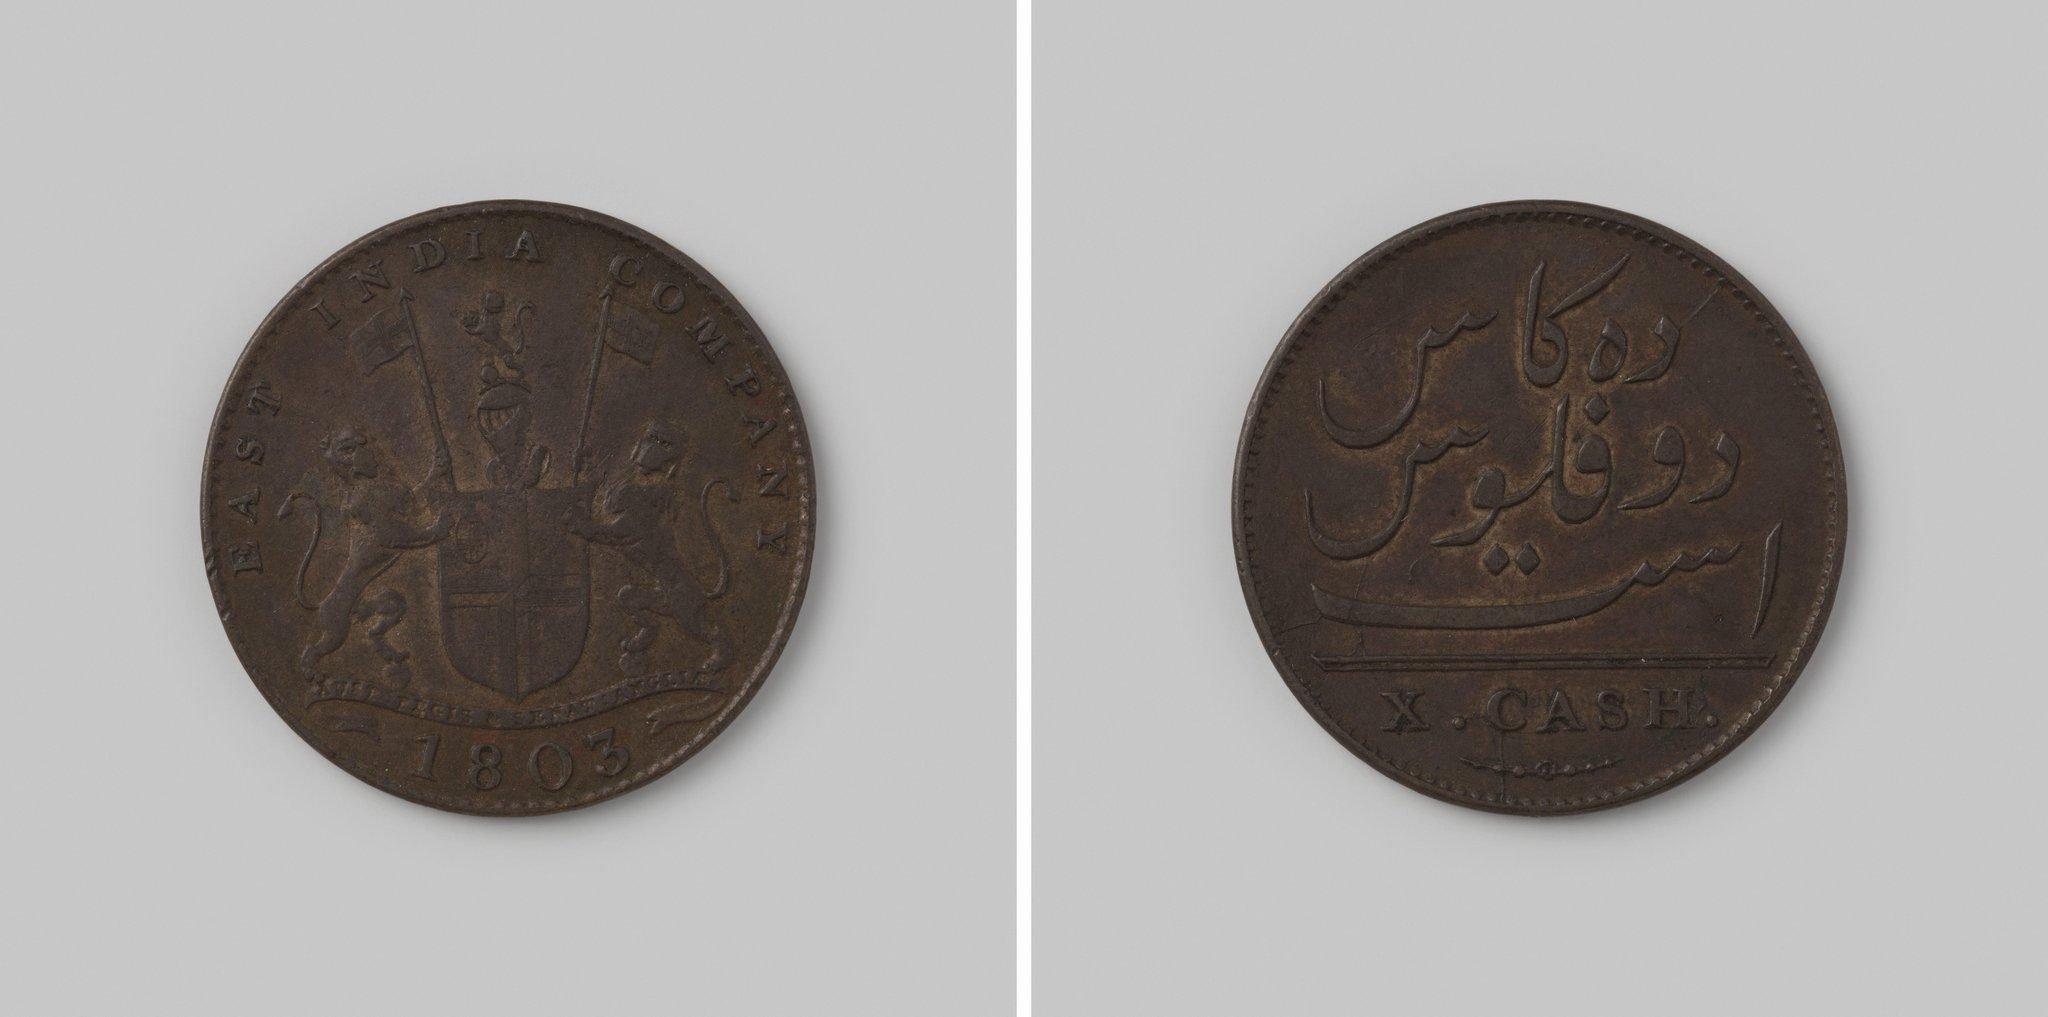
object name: coin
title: 10 cash voor Madras in India van de Engelse Oostindische Compagnie (EIC), 1803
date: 1803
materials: copper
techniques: striking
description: Koperen munt. Voorzijde: door twee op banderol, waarin opschrift, staande leeuwen met pijl, waaraan vlag, in de klauw, gehouden wapenschild van de EIC, waarboven helmteken. Jaartal onderaan. Keerzijde: Bovenaan in drie regels waarde-aanduiding in Arabische lettertekens. In afsnede waarde-aanduiding in het Engels: X. Cash. Gladde rand. Geslagen in Engeland.